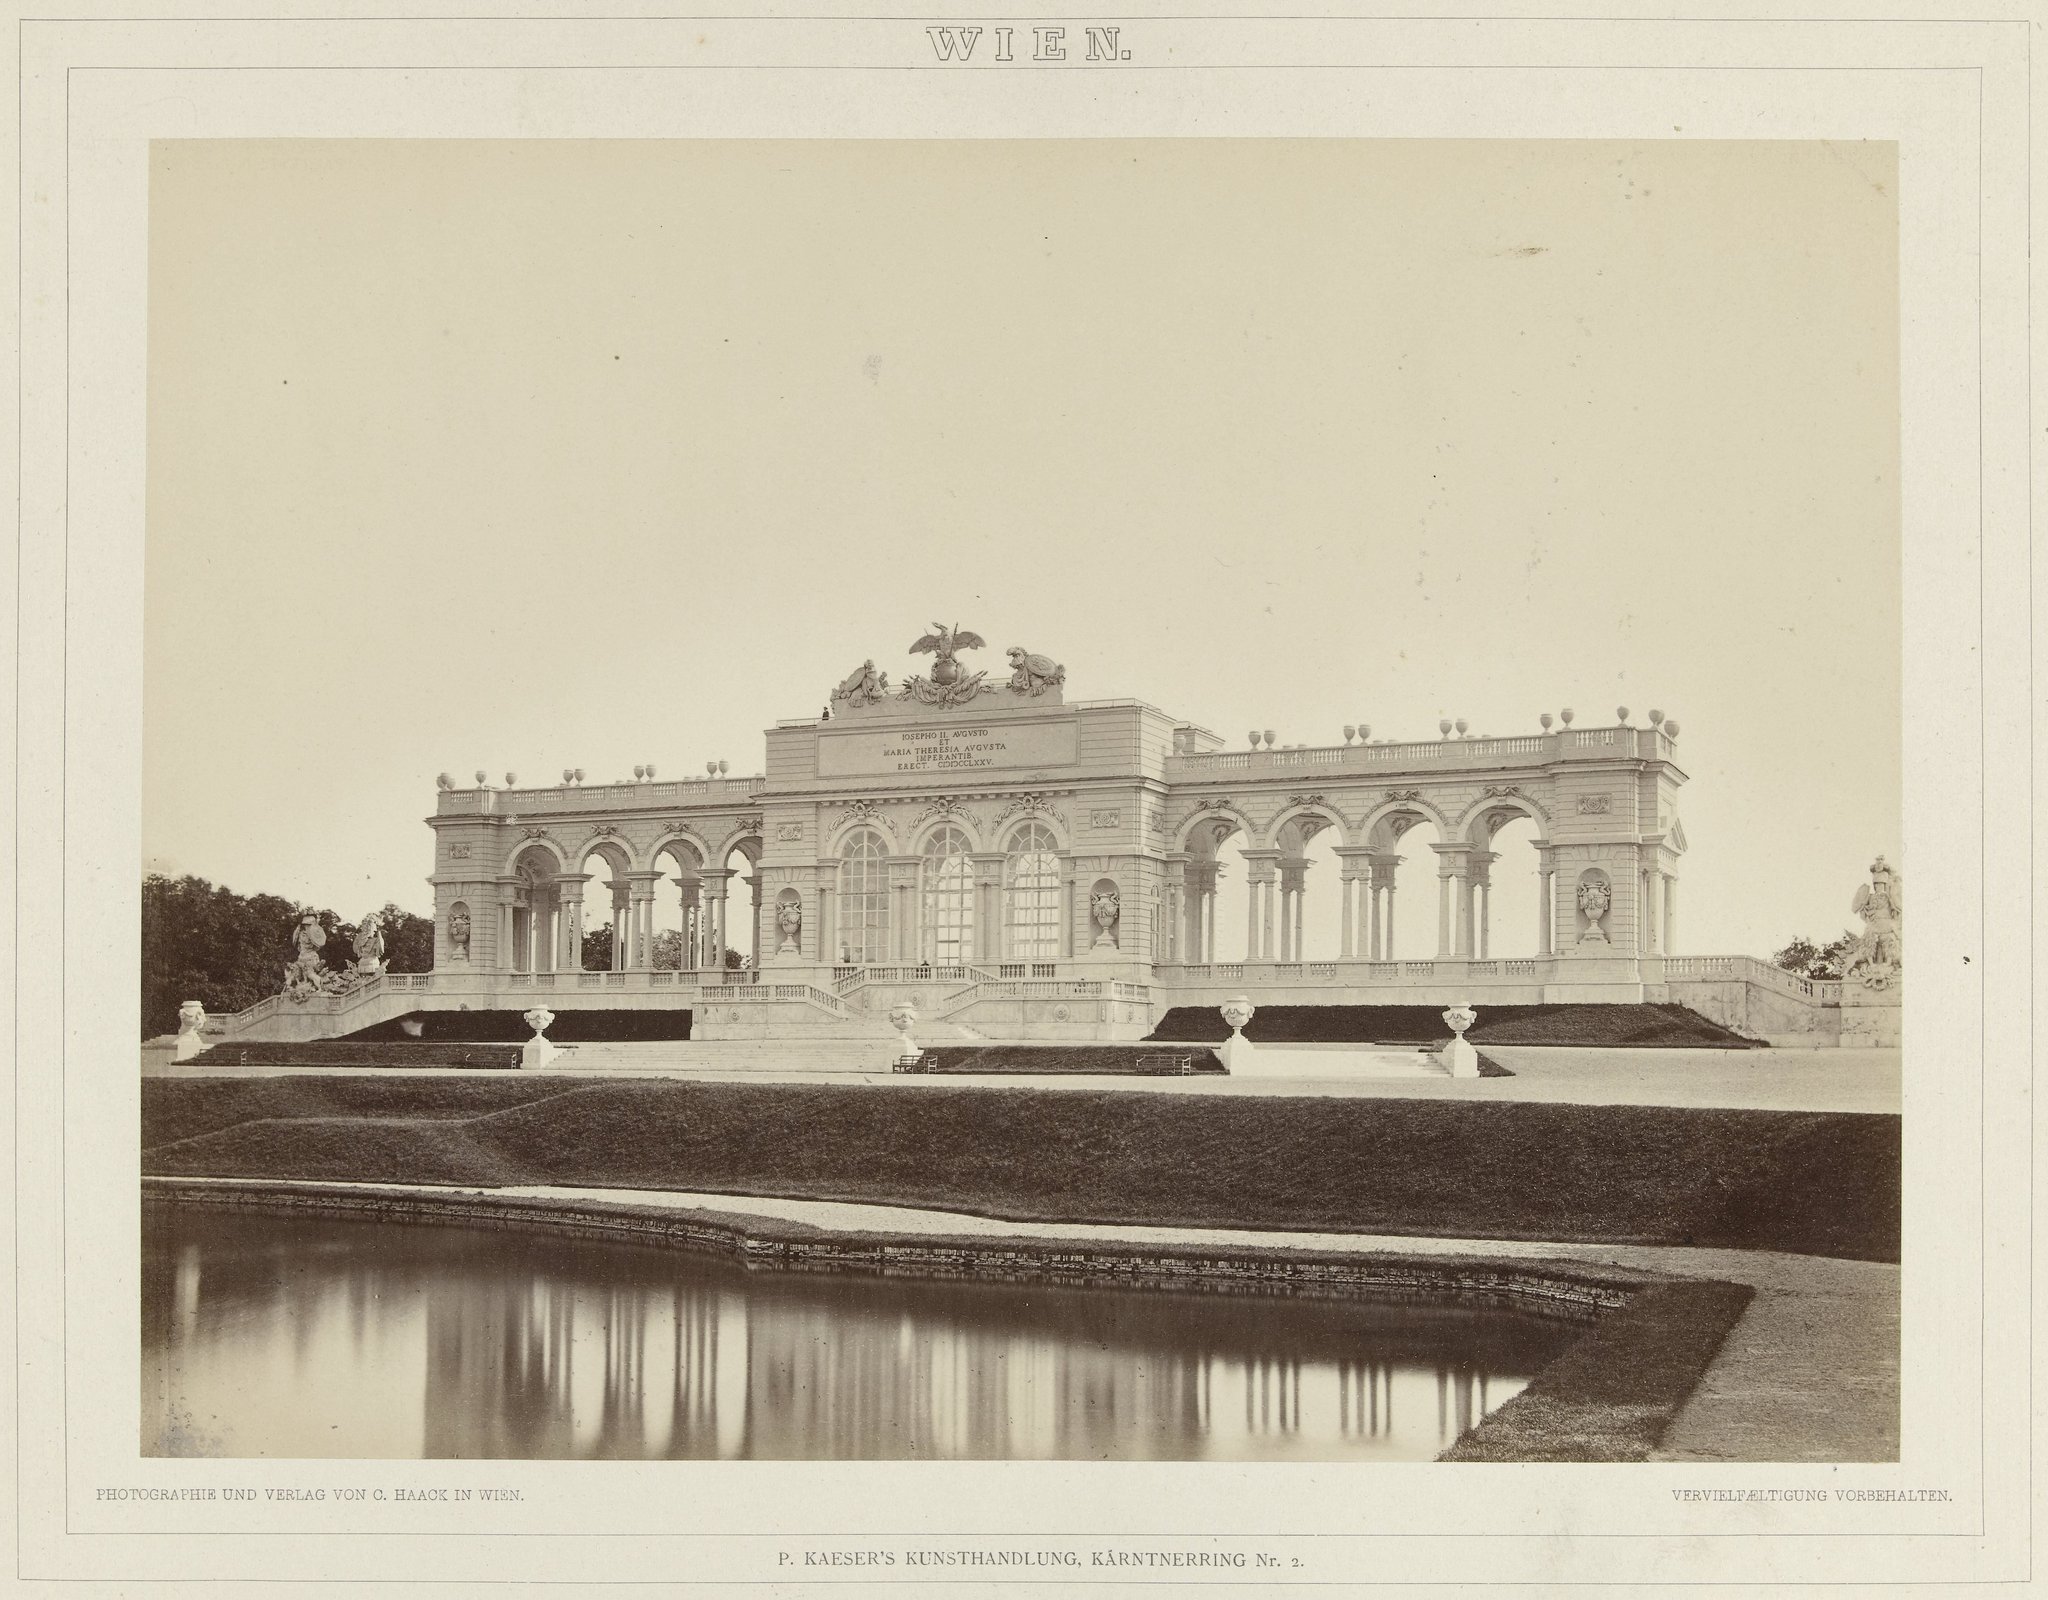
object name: photograph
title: Gezicht op de Gloriette in de tuin van paleis Schönbrunn in Wenen, Oostenrijk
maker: carl haack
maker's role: fotograaf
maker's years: 1842-1908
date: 1880-1900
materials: cardboard, paper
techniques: albumen print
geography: vienna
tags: garden buildings, greenhouse, orangery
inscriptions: inscription: ‘J.R. de Kruyter [?]’, inscription: ‘Schönbrun Gloriettes’, retailer's mark: ‘P. KAESER'S KUNSTHANDLUNG, KÄRNTNERRING Nr. 2.’, inscription: ‘VERVIELFAELTIGUNG VORBEHALTEN.’